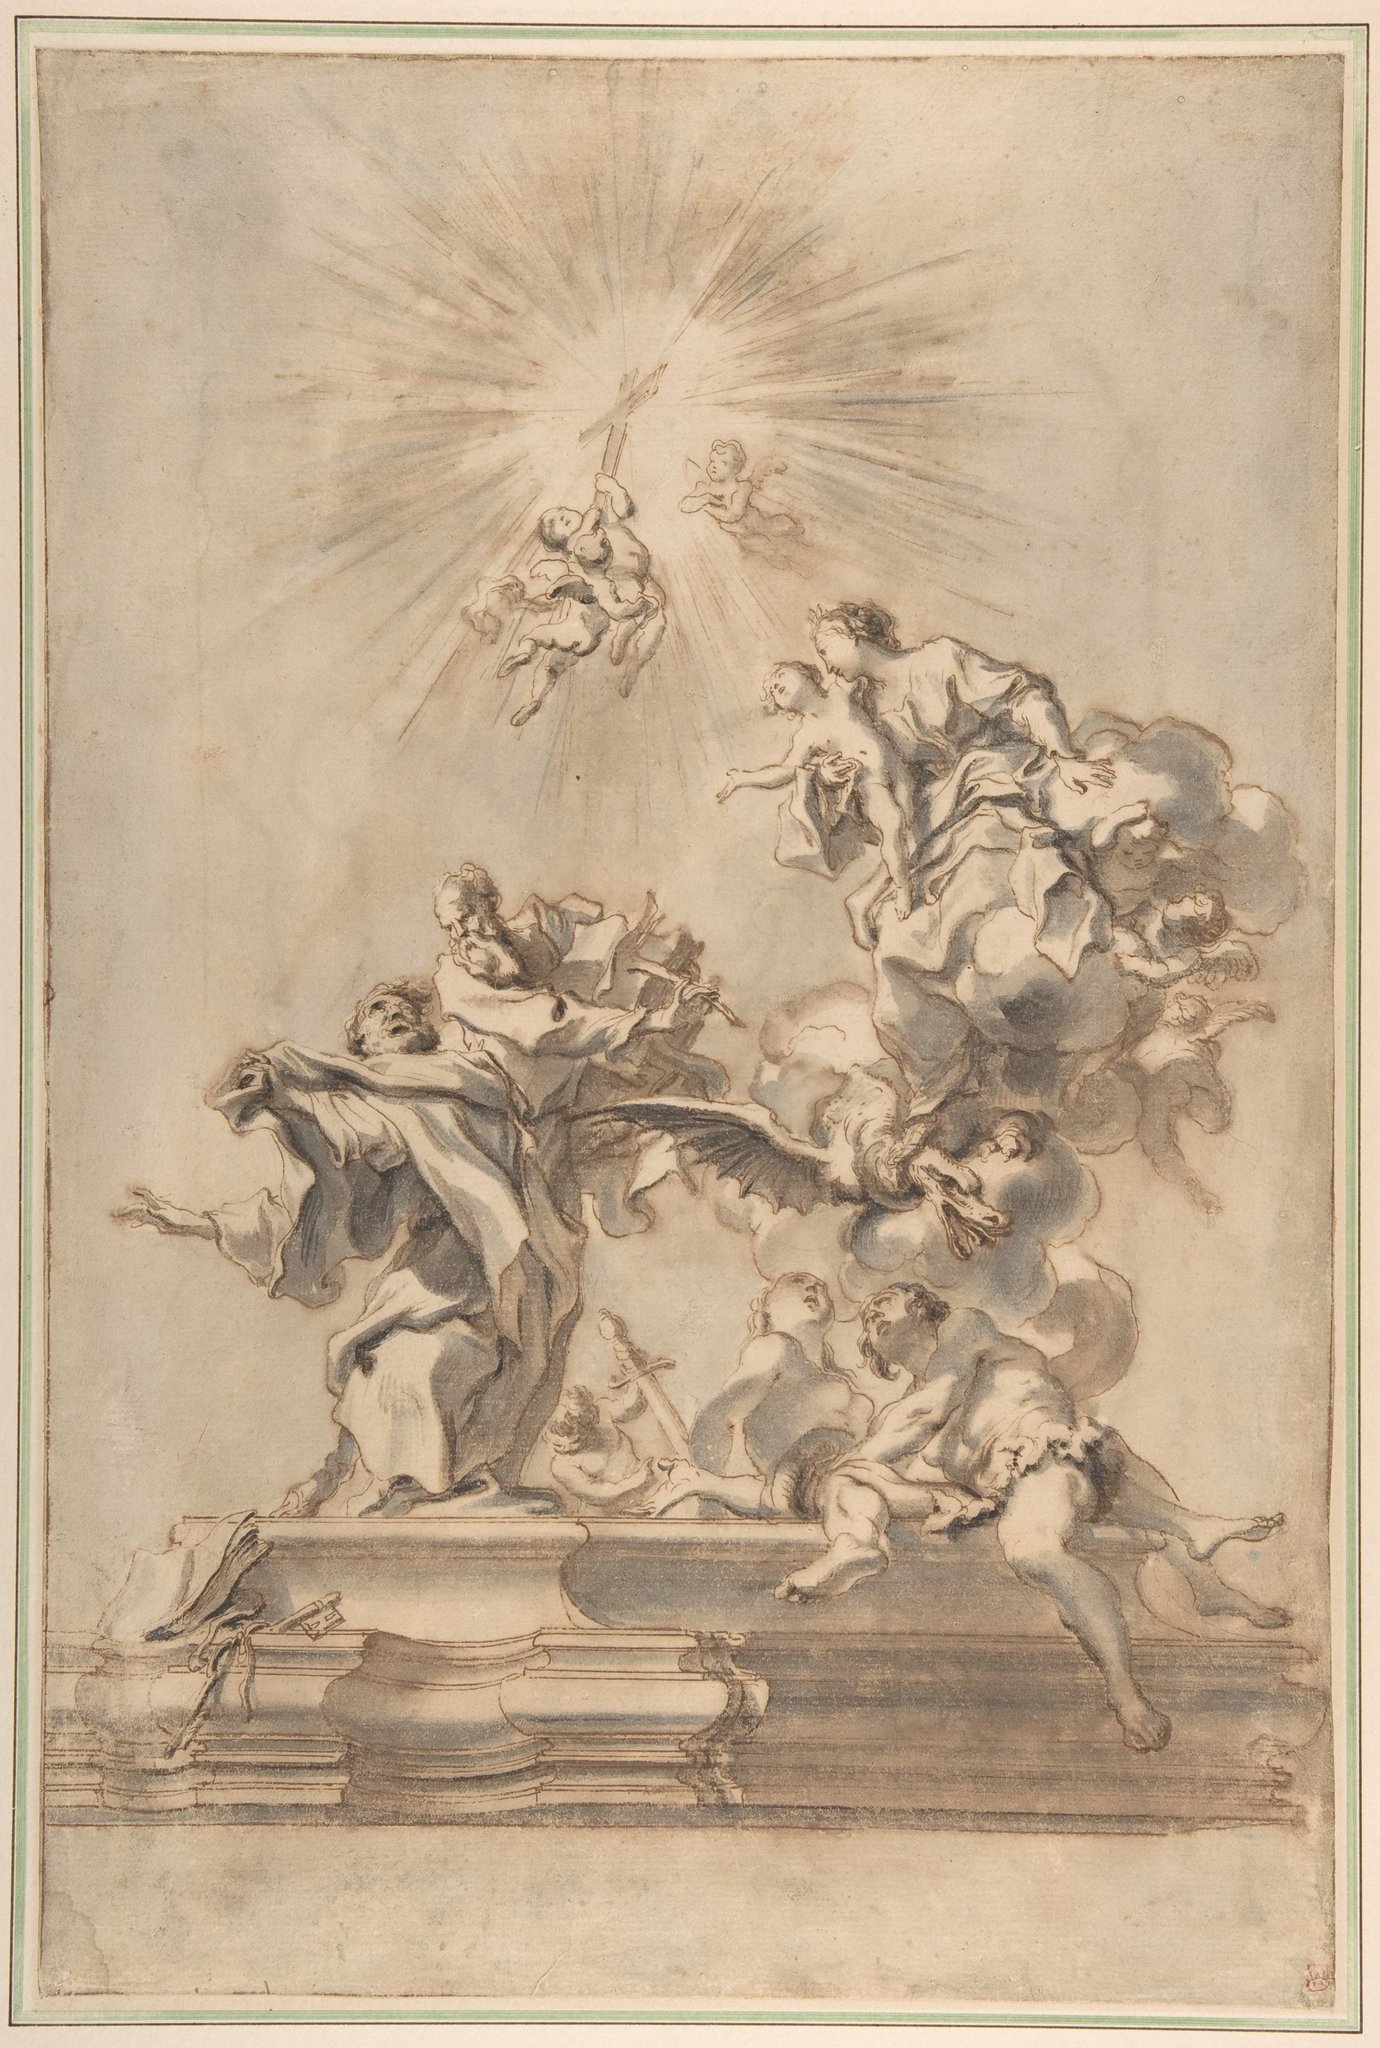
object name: drawing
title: The Ascension of the Virgin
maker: gregorio de' ferrari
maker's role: artist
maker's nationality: italian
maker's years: 1647-1726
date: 1667-1726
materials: ink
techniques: brush, pen, wash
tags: angels,virgin mary,cross